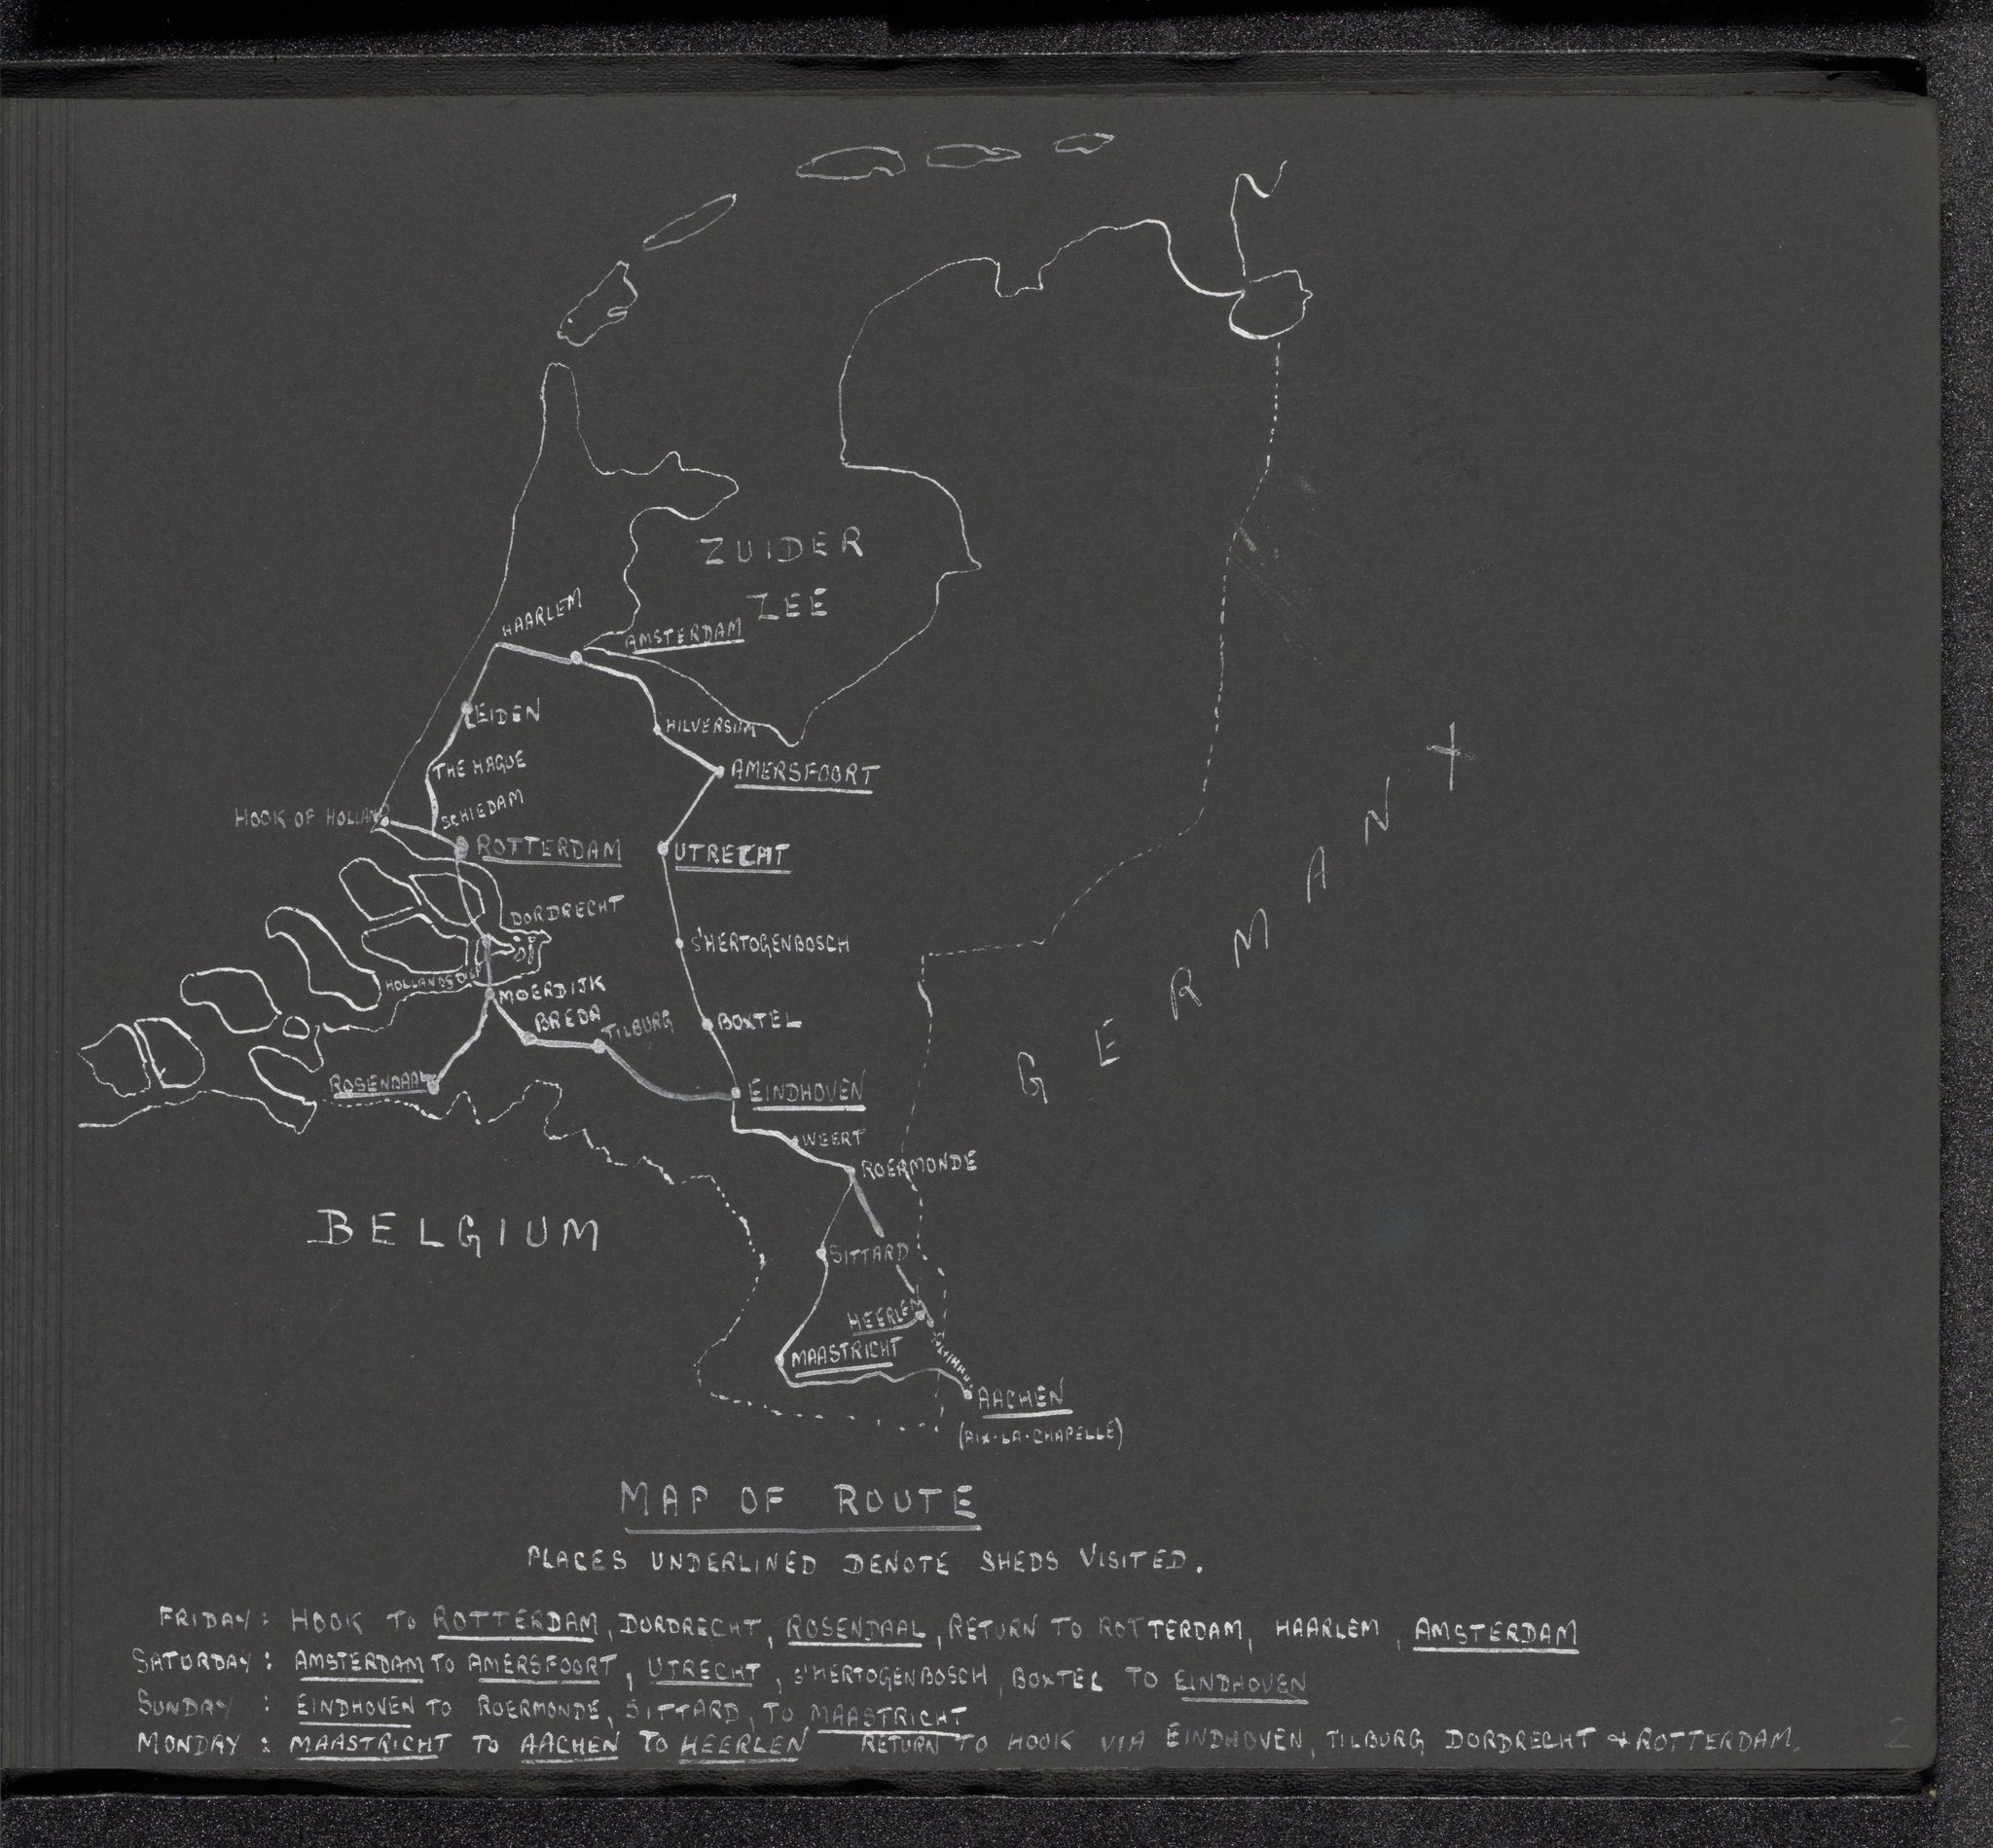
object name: album leaf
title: Plattegrond van de door de Stephenson Locomotive Society in Nederland afgelegde reisroute met reisdatums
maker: Anonymous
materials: cardboard, ink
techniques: writing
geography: great britain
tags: locomotive, maps, atlases, railway, train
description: Onderdeel van Fotografische reisverslag van het bezoek van de Stephenson Locomotive Society aan Nederland.